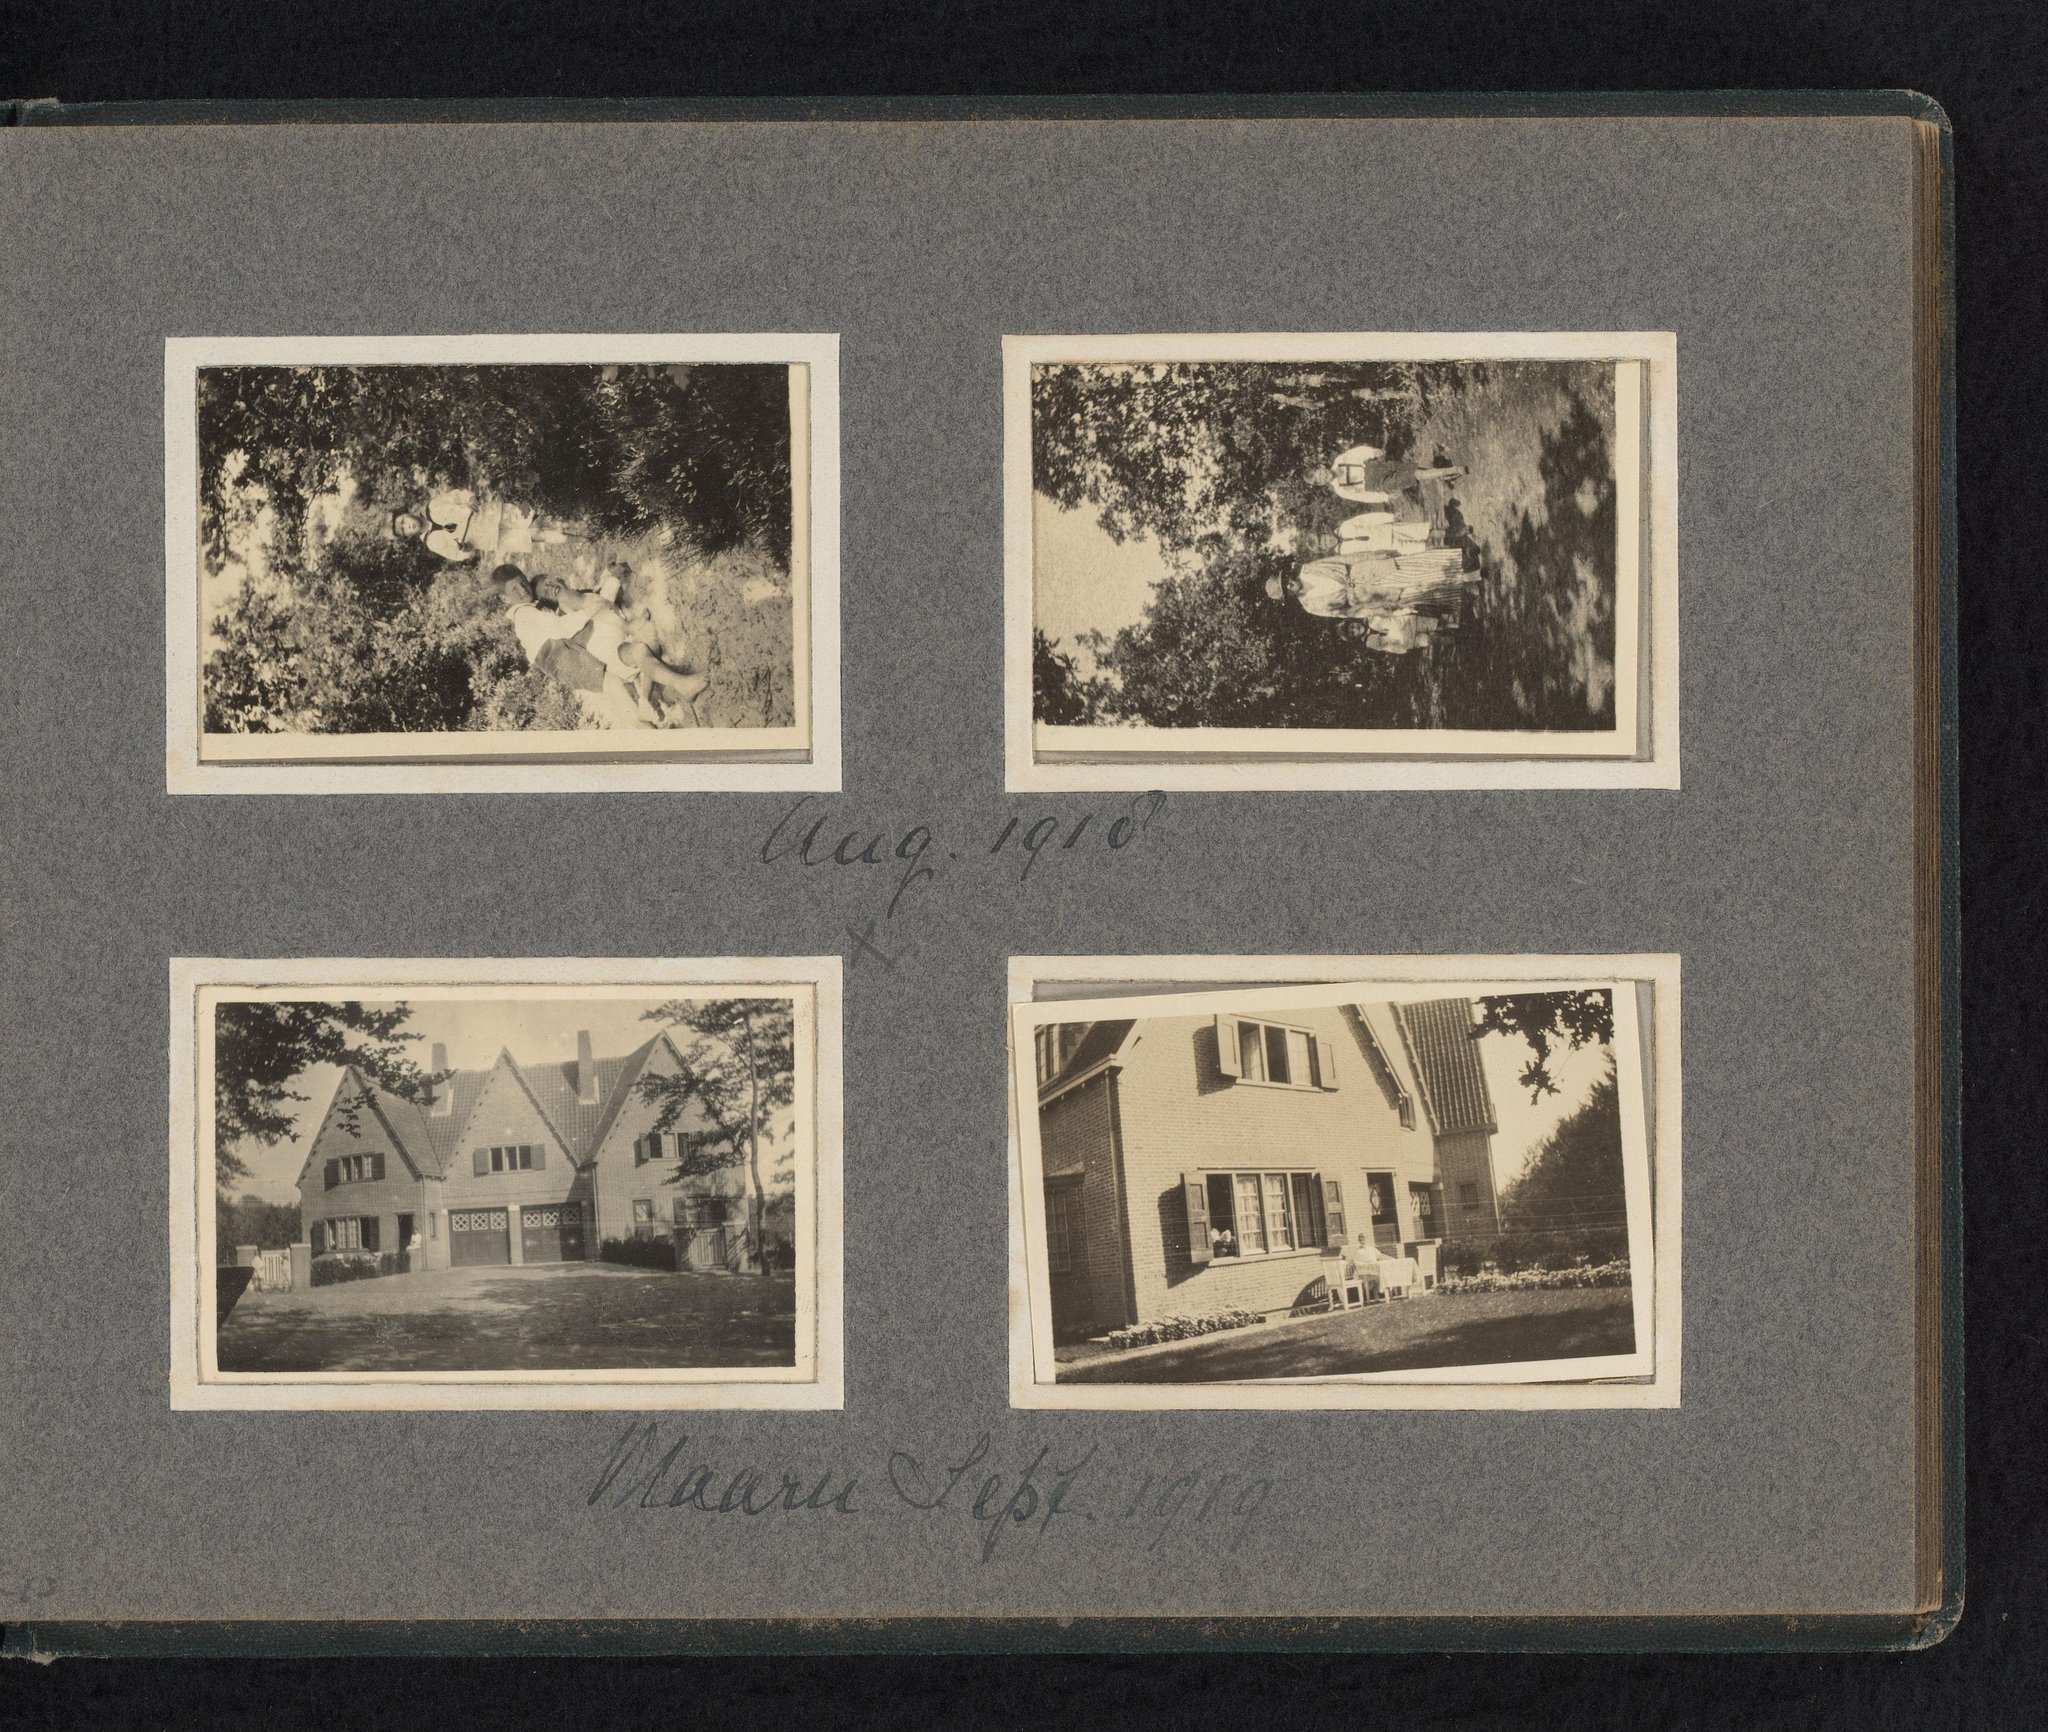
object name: photograph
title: Familie van den berg in Maarn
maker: hendrik herman van den berg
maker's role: amateurfotograaf, jurist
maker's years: 1875-1944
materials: paper, cardboard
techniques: gelatin silver print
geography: maarn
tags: family life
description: Deze foto's zijn onderdeel van een album.